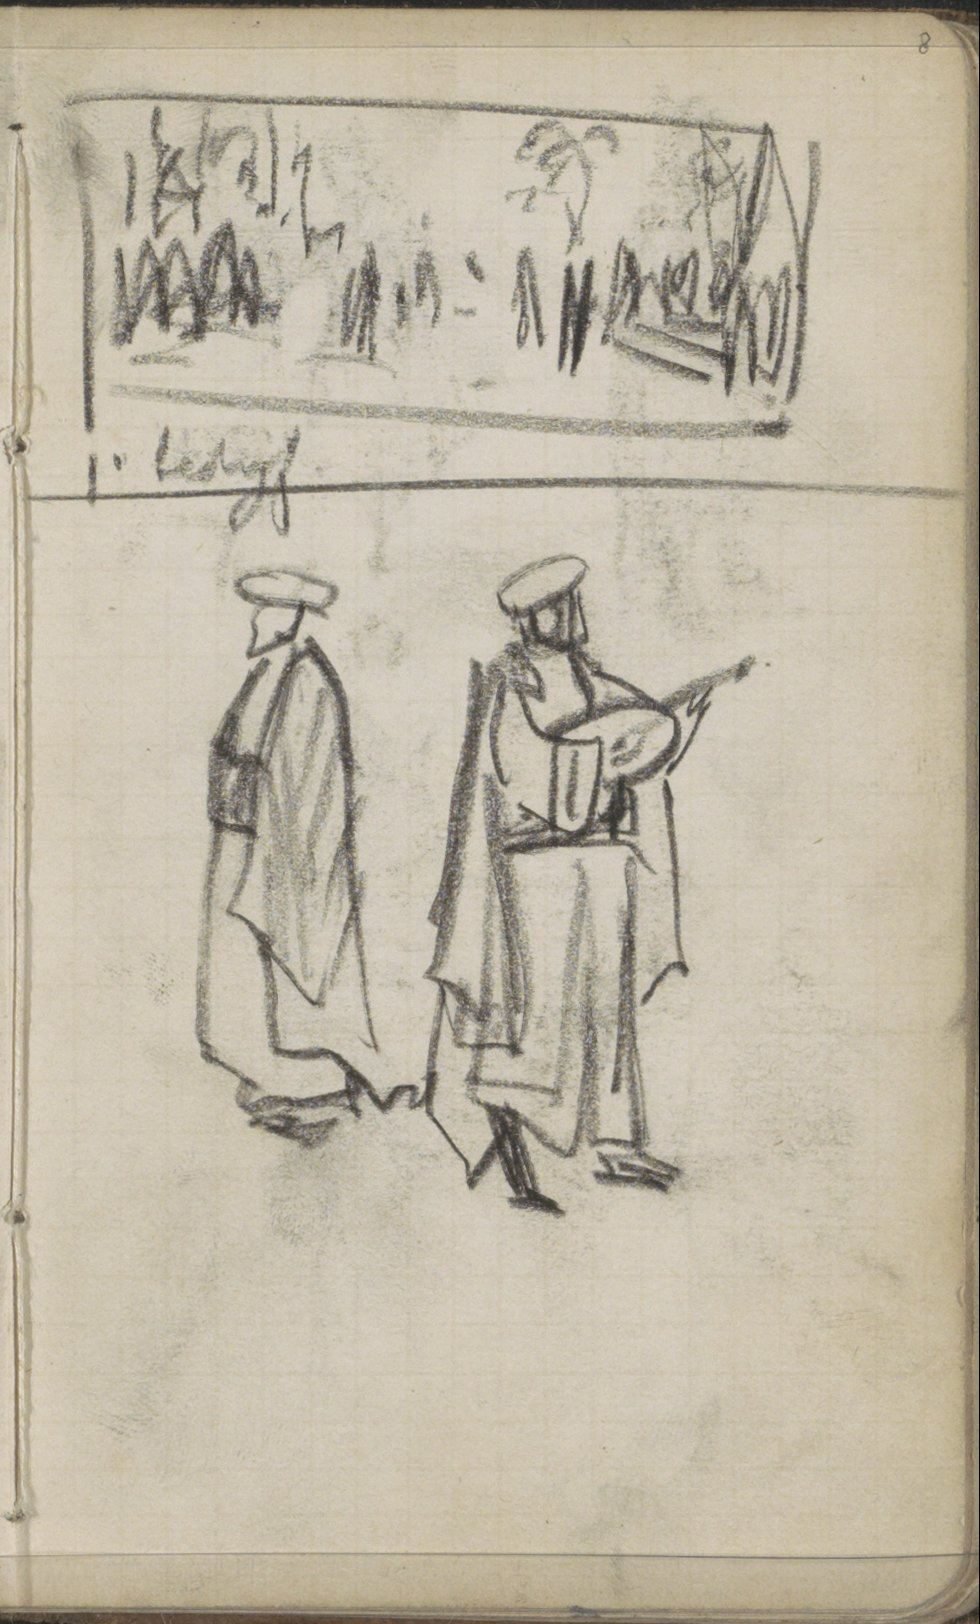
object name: sketchbook leaf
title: Decor en figuurstudies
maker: marius bauer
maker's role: draughtsman, print maker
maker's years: 1867-1932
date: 1879-1885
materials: chalk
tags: standing figure, theatre, theatrical performance, adult man, historical costume, lute, and special forms of lute, e.g.: theorbo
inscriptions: annotation: ‘1e bedrijf’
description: Onder andere een luitspeler. Pagina 8 uit een schetsboek met 58 bladen.